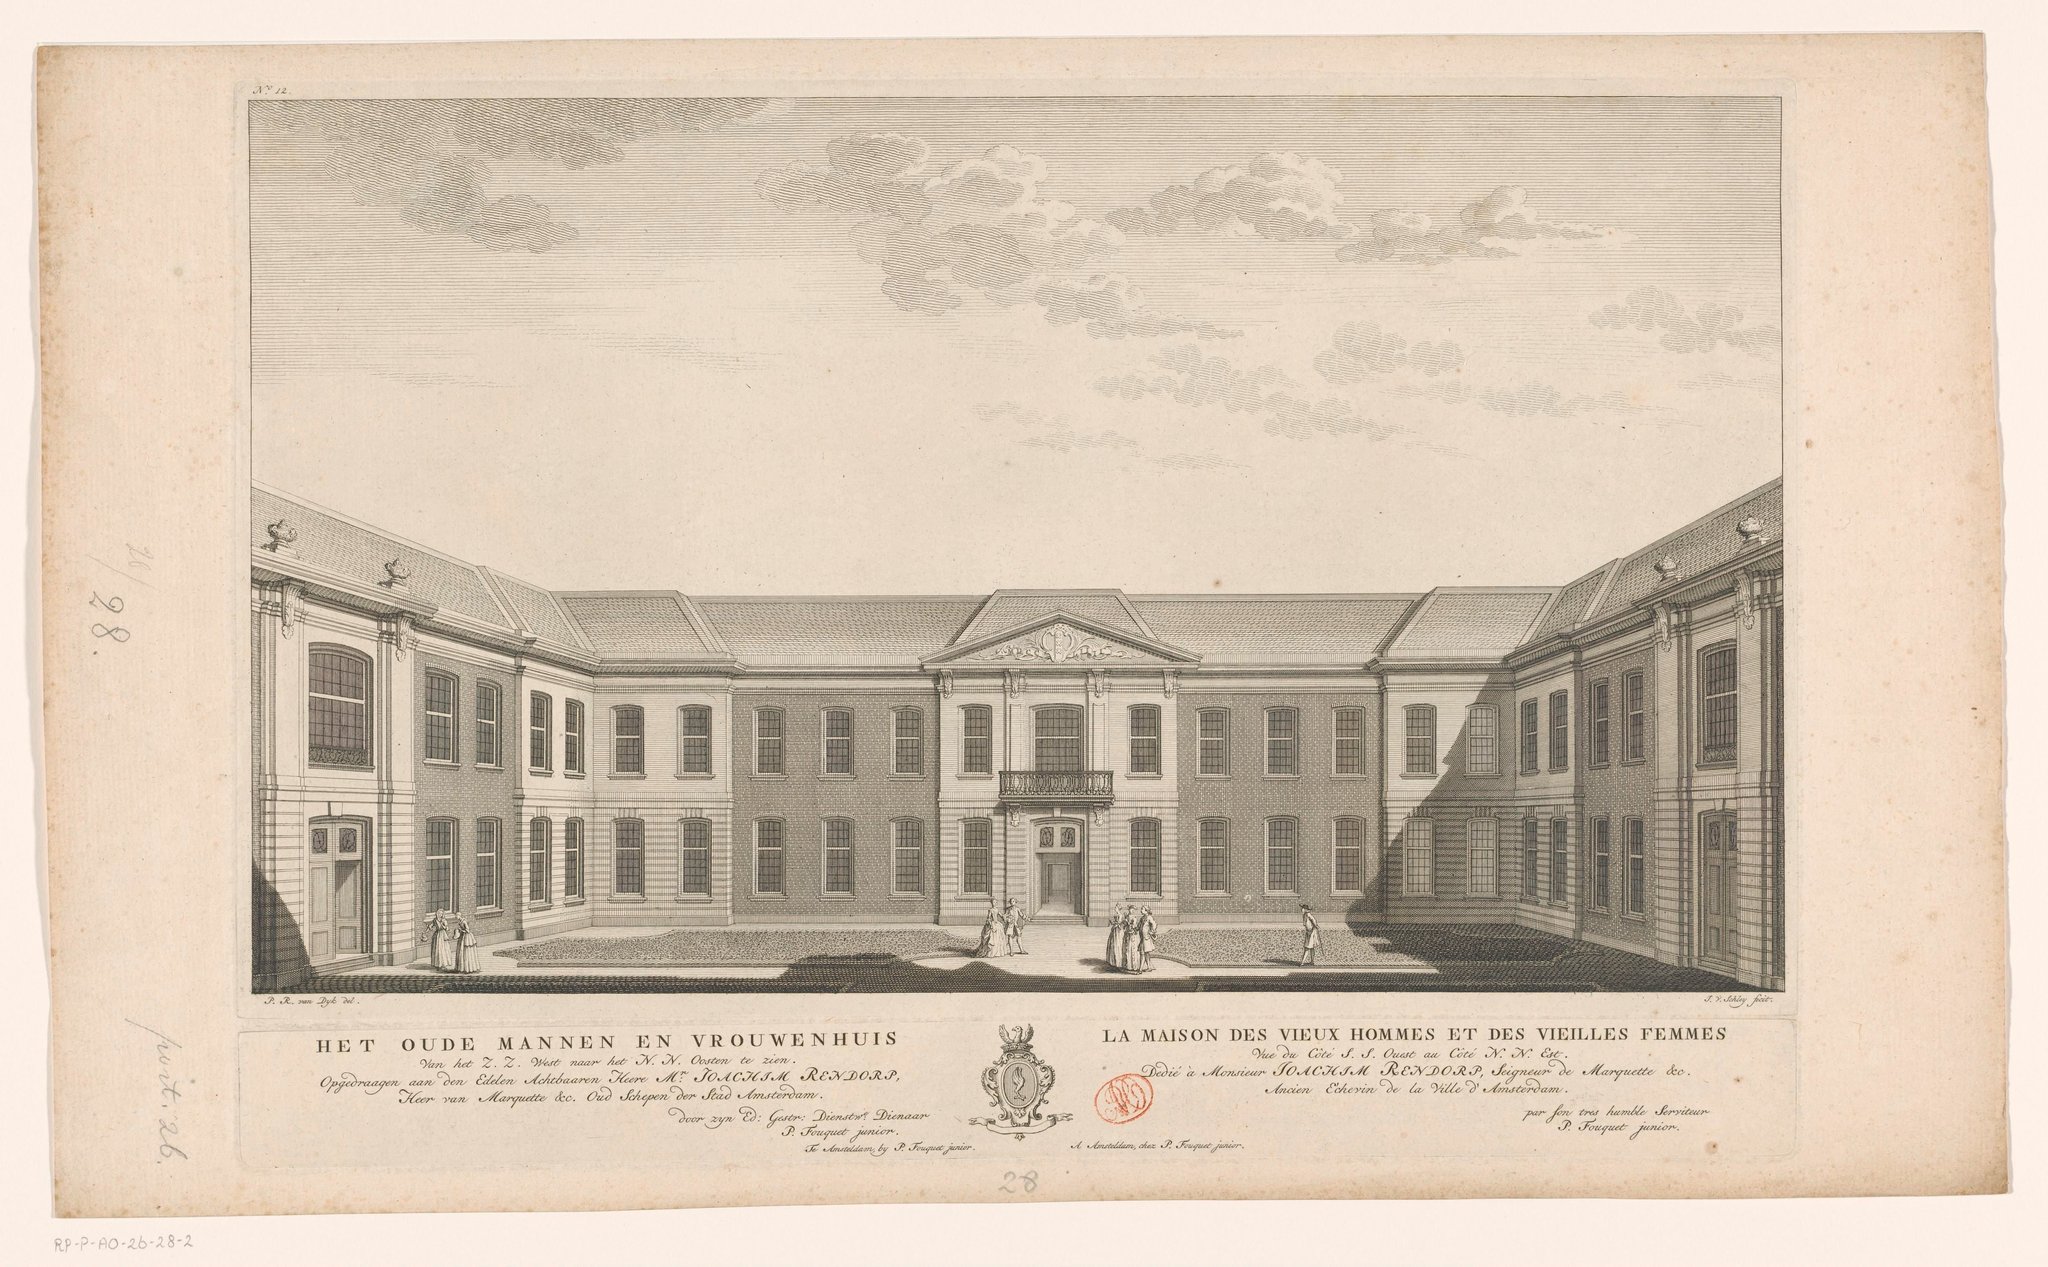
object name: print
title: Het Oude Mannen en Vrouwenhuis Van het Z.Z. West naar het N.N. Oosten te zien / La Maison des Vieux Hommes et des Vieilles Femmes Vue du Côté S.S. Ouest au Côté N.N. Est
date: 1760-1783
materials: paper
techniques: engraving, etching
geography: amsterdam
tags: amsterdam, joachim rendorp, public welfare, poorhouse, courtyard, armorial bearing, heraldry, old-people's home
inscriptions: collector's mark: Lugt 195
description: Deze prent is ook gebruikt in de zogenaamde Atlas van Fouquet.* Pierre Fouquet gaf vanaf 1760 stadsgezichten van Amsterdam - naar tekeningen van verschillende kunstenaars, gemaakt door verschillende prentmakers - uit. Deze prenten werden aanvankelijk los of in series verkocht. Zoals toen gebruikelijk kon de koper de prenten zelf laten inbinden. Hiertoe gaf Fouquet tussen 1778 en 1783 een titelblad, plattegrond en inhoudsopgave van de tot dusver 100 uitgegeven prenten uit (1). Gezien de inhoud afhankelijk was van wat de koper had verzameld verschilt de inhoud van de verschillende bewaarde Fouquetatlassen onder deze titel sterk. Ook zijn er exemplaren bekend waar tevens andere prenten aan zijn toegevoegd. Omdat er behoefte bleek aan uitleg bij de platen werd in 1783 een nieuwe versie van de atlas uitgegeven, aangevuld met tekst en twee prenten. De aangegeven volgorde veranderde maar de platen van de al eerder uitgegeven prenten bleven ongewijzigd. Deze uitgave werd in opdracht van Fouquet gedrukt bij Daniël Jean Changuion en Petrus den Hengst (2). Een tiental platen werd bijgewerkt en verscheen, met nieuw impressum, in het vervolg van Wagenaars geschiedenis van Amsterdam, uitgeven door Petrus Conradi en Folkert van der Plaats (3). Een aantal jaar na het overlijden van Fouquet kwam Evert Maaskamp met een nieuwe uitgave van de atlas, met verbeterde tekst en toevoeging van twee prenten. Op alle platen verwijderde hij het oude en liet hij zijn eigen impressum zetten (4). De huidige staat van de prent komt voor in exemplaren van de onder (1) en (2) genoemde werken. * Onder de Atlas van Fouquet of Fouquetatlas verstaan we de hieronder vermelde publicaties (1), (2) en (4). (1). Afbeeldingen van de wyd-vermaarde koopstad Amsterdam benevens des zelvs voornaamste gebouwen en gezigten alle naar het leeven getekend / Receuil des edifices les plus considerables et des plus belles vues, de la fameuse ville d'Amsterdam, dessinées d'après nature. Amsterdam: Pierre Fouquet, 1778-1783. (2). Nieuwe atlas, van de voornaamste gebouwen en gezigten der stad Amsterdam, met derzelver beknopte beschryvingen. 2 delen. Amsterdam: Daniël Jean Changuion en Petrus den Hengst [in opdracht van Pierre Fouquet], 1783. (3). Stijl, Simon. Amsterdam, in zyne geschiedenissen, voorregten, koophandel, gebouwen, kerkenstaat, schoolen, schutterye, gilden en regeeringe, beschreeven. Om te dienen ten vervolge op het werk van Jan Wagenaar (…). 10 delen. Amsterdam en Harlingen: Petrus Conradi en Folkert van der Plaats, 1788-1801. (4). Nieuwe atlas, van de voornaamste gebouwen en gezigten der stad Amsterdam. Met derzelver beknopte beschryvingen. Amsterdam: Evert Maaskamp, 1805. * Het aantal vermelde staten is gebaseerd op het aantal gevonden staten. Mogelijk zijn er meer staten van deze prent.